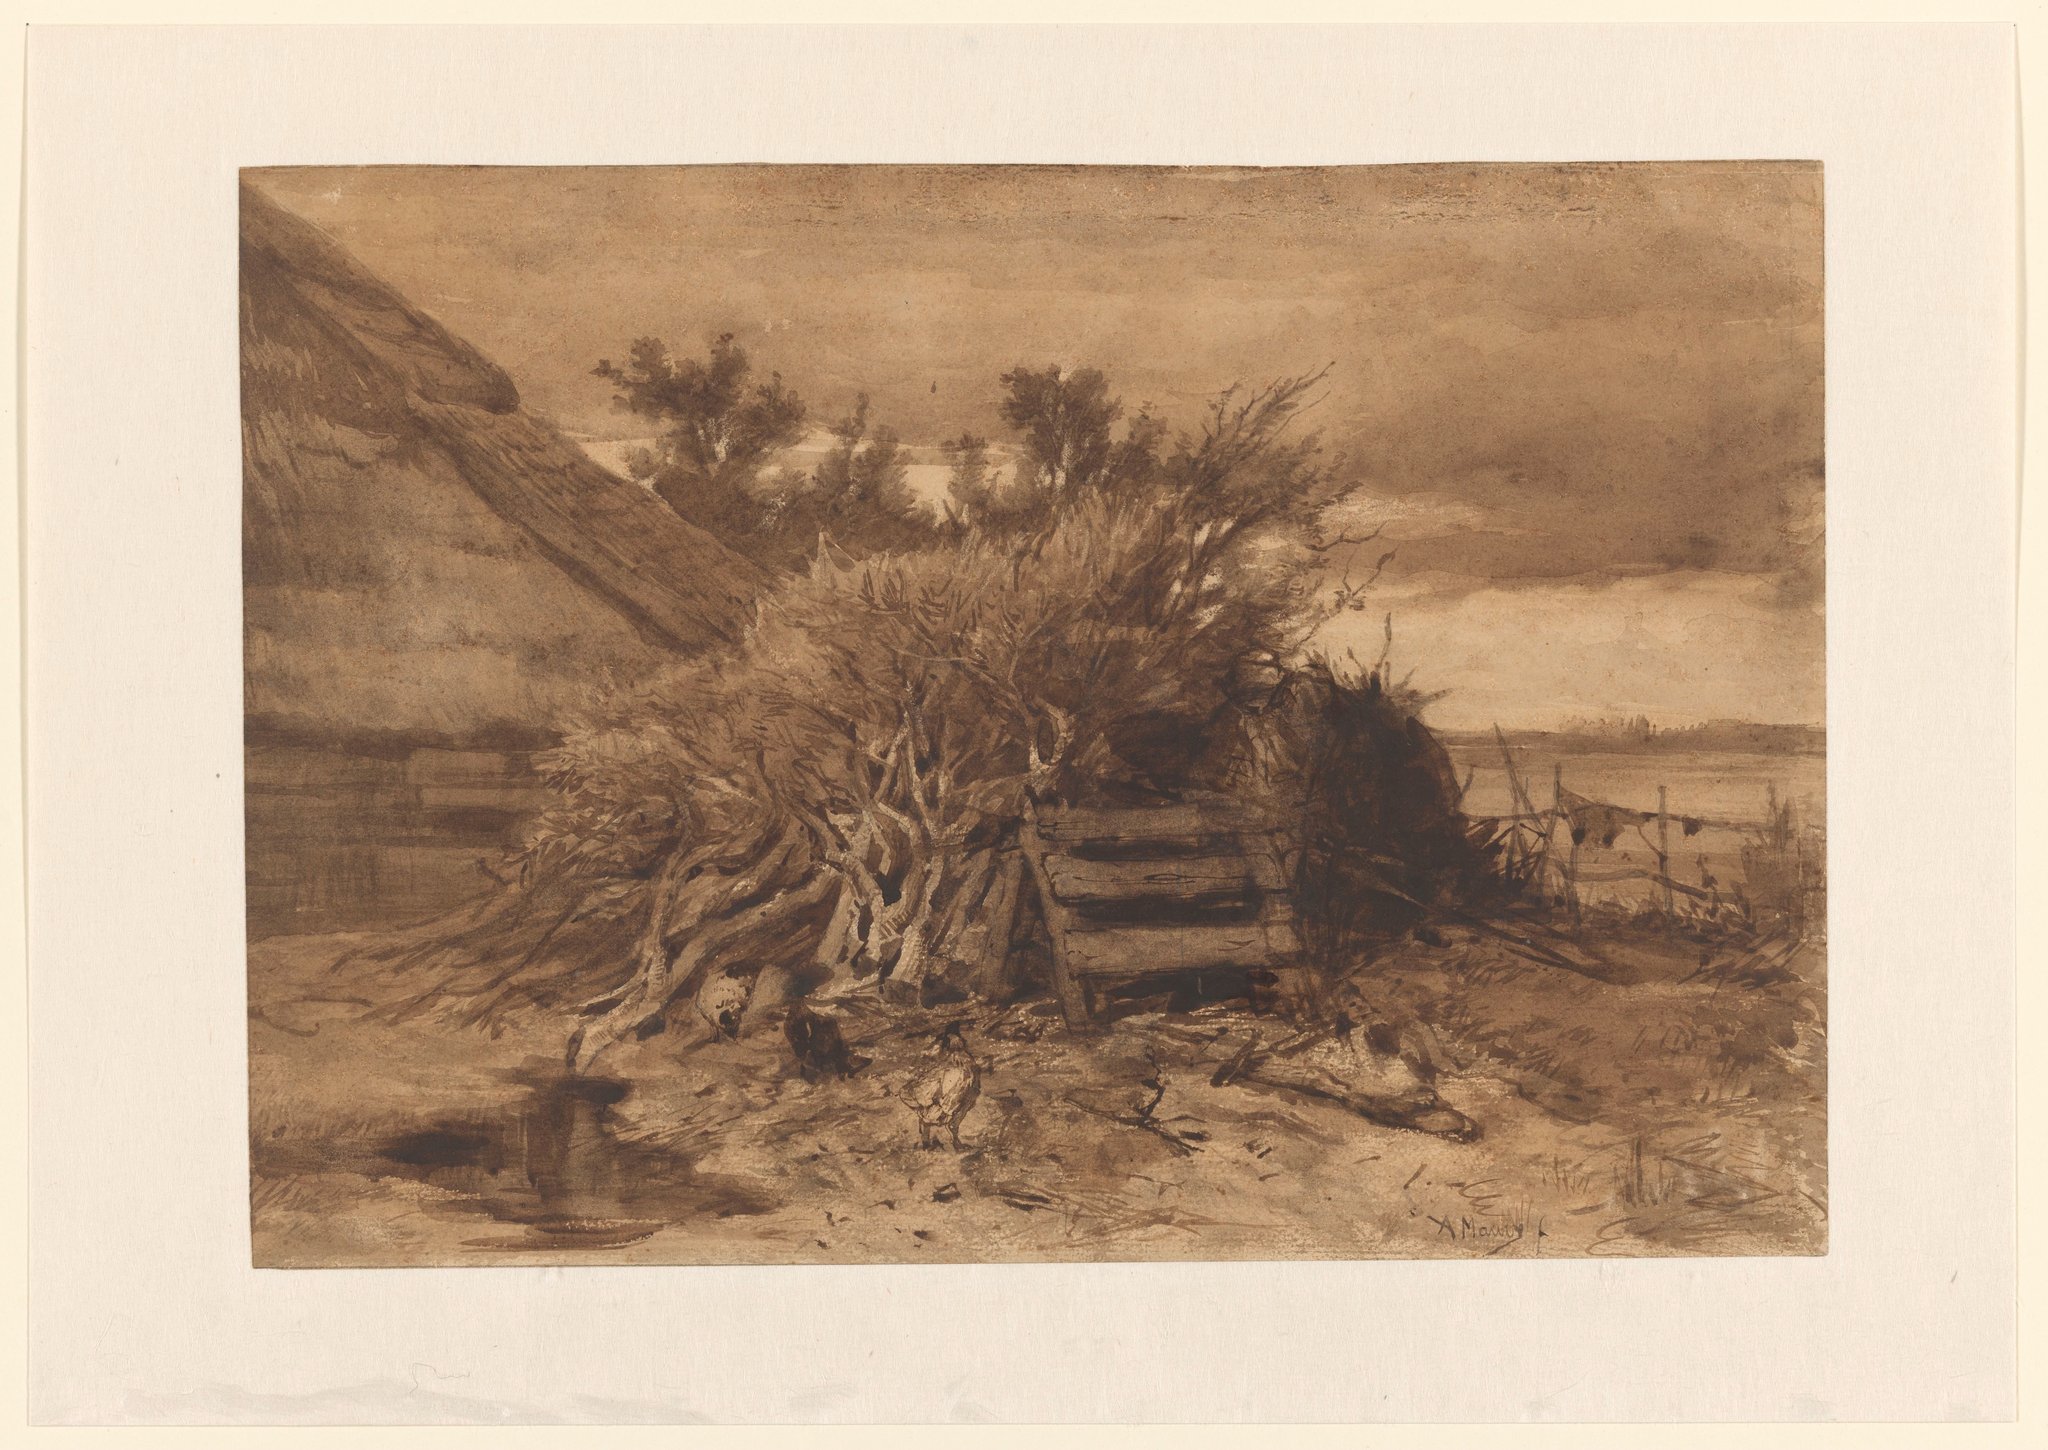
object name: drawing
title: Achter het postkantoor te Oosterbeek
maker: anton mauve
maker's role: draughtsman, painter, print maker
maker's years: 1838-1888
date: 1865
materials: paper, pencil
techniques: brush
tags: oosterbeek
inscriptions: signature: ‘A Mauve f’, inscription: ‘achter 't postkantoor Oud. Oosterbeek’